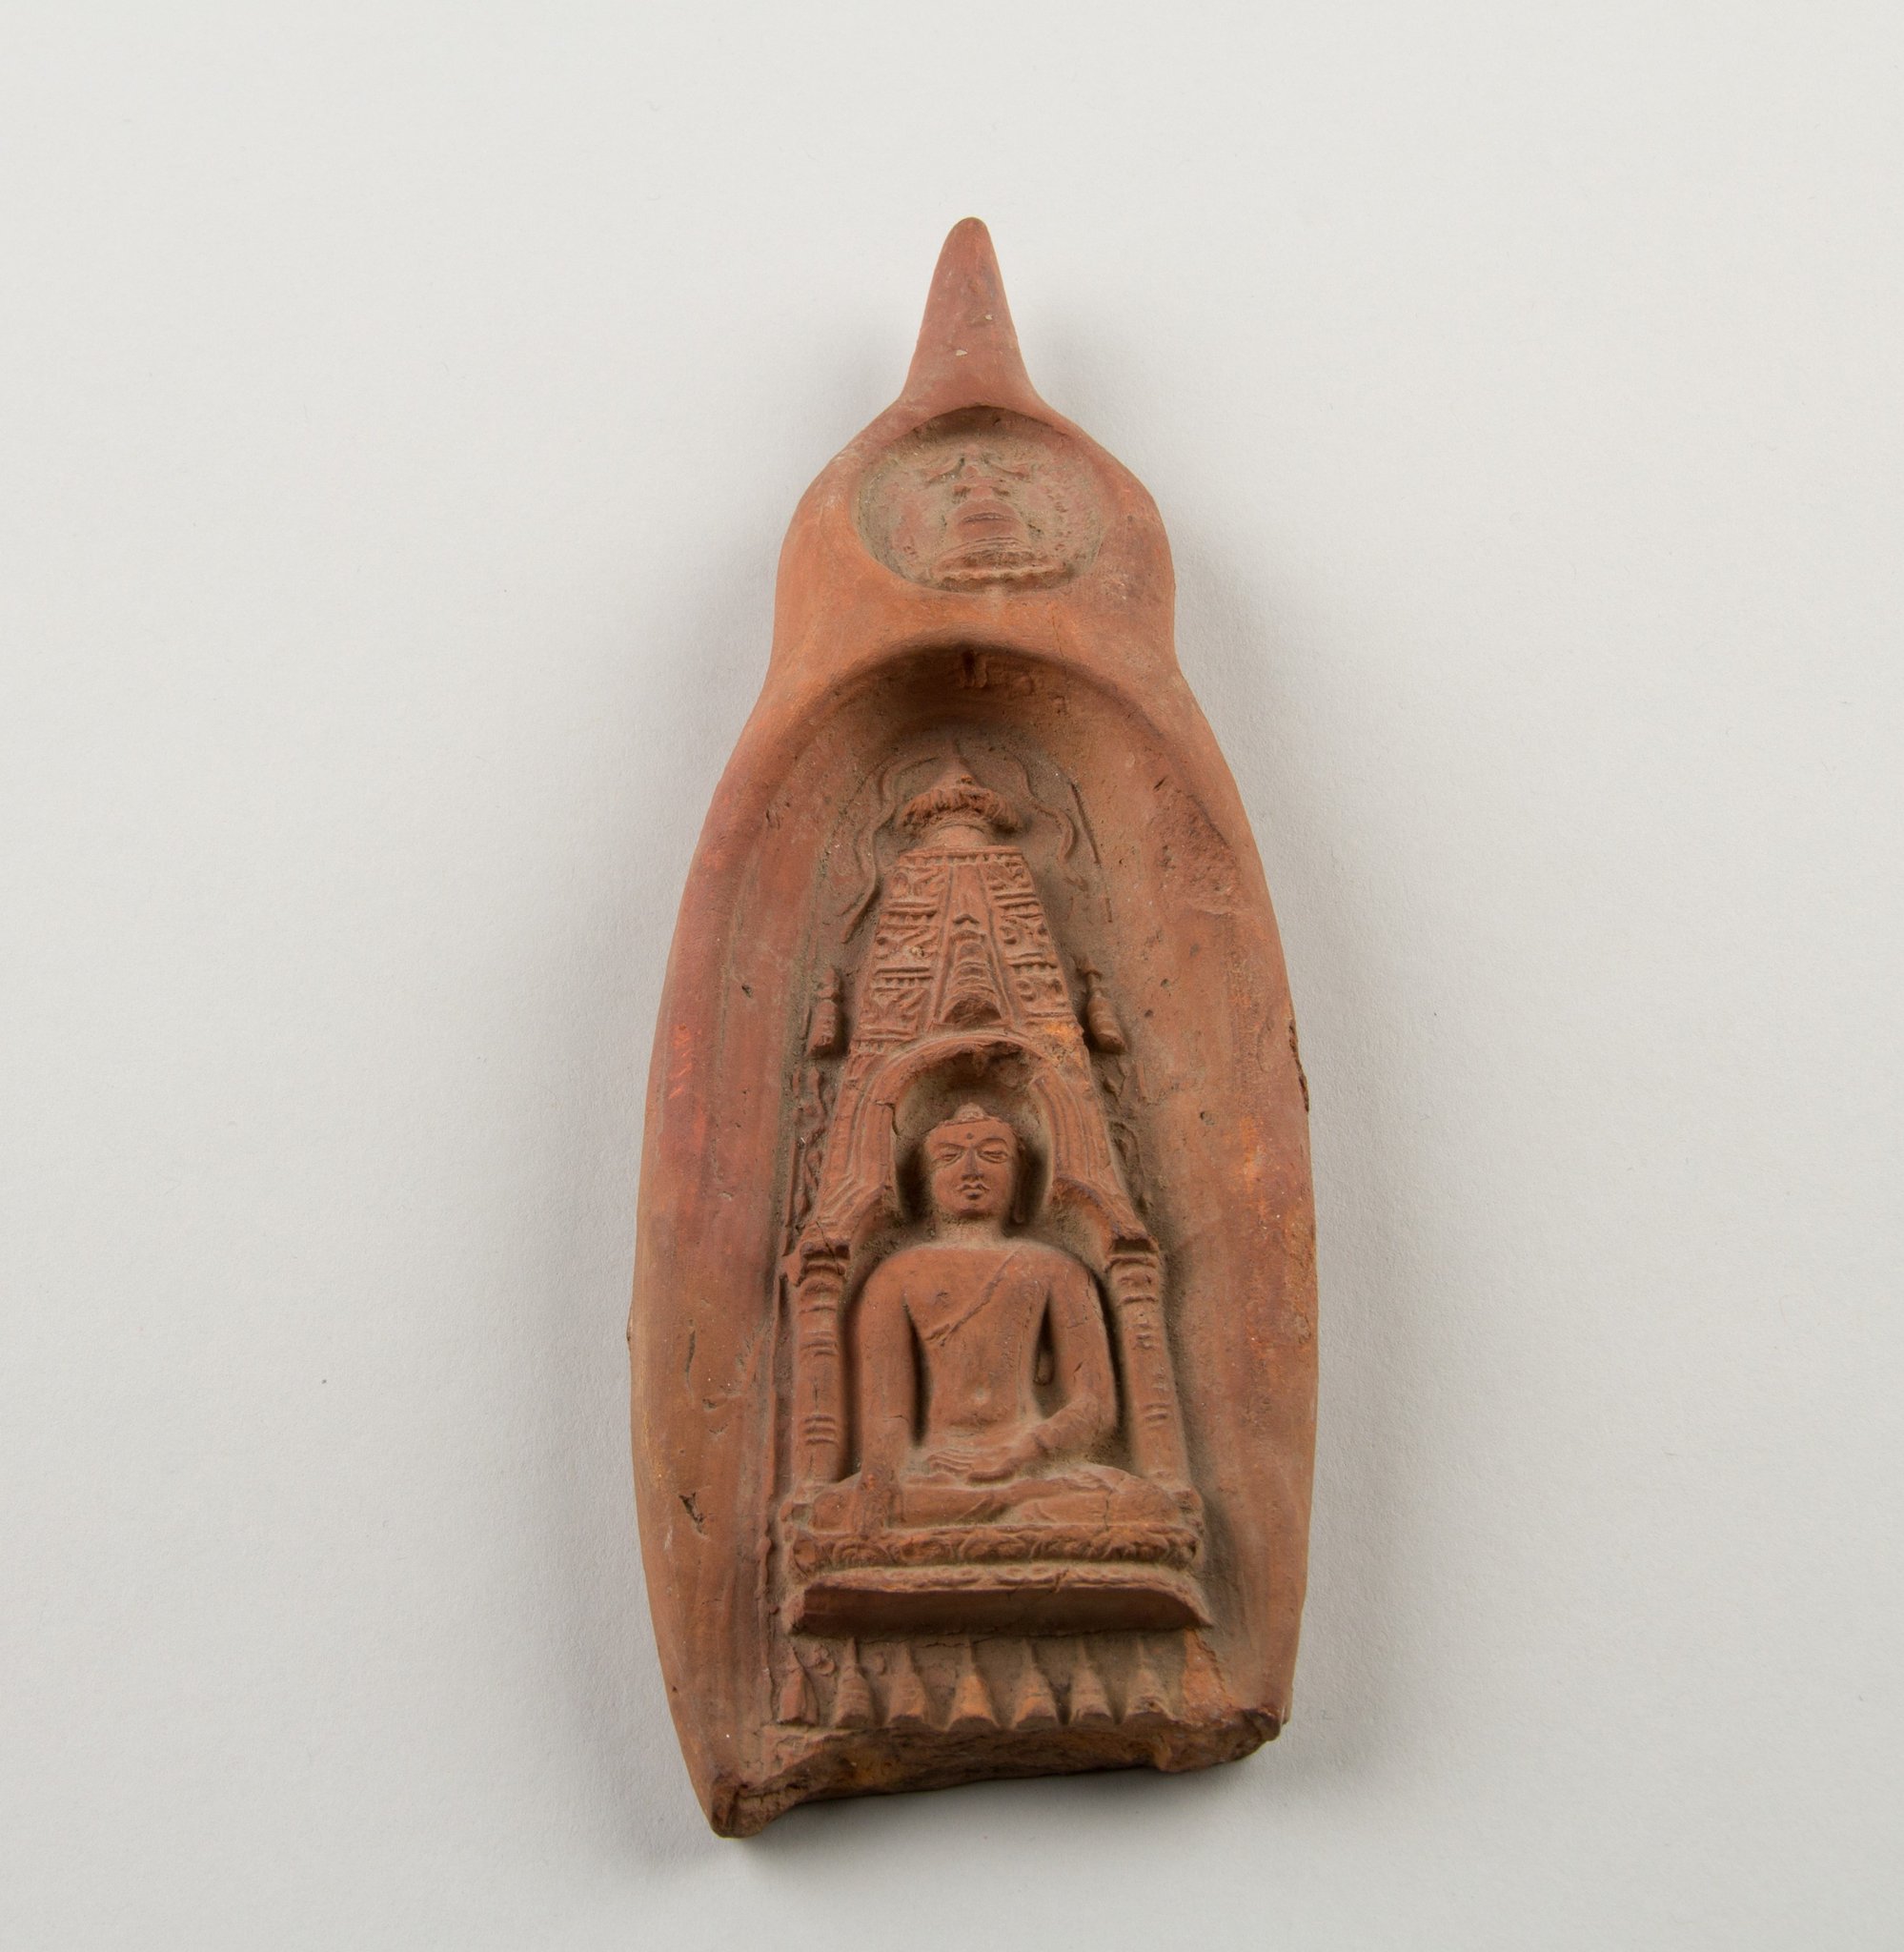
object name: sealing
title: Sealing Depicting the Buddha at the Mahabodhi Temple, Bodhgaya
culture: indian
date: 801-900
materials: terracotta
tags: buddhism,buddha